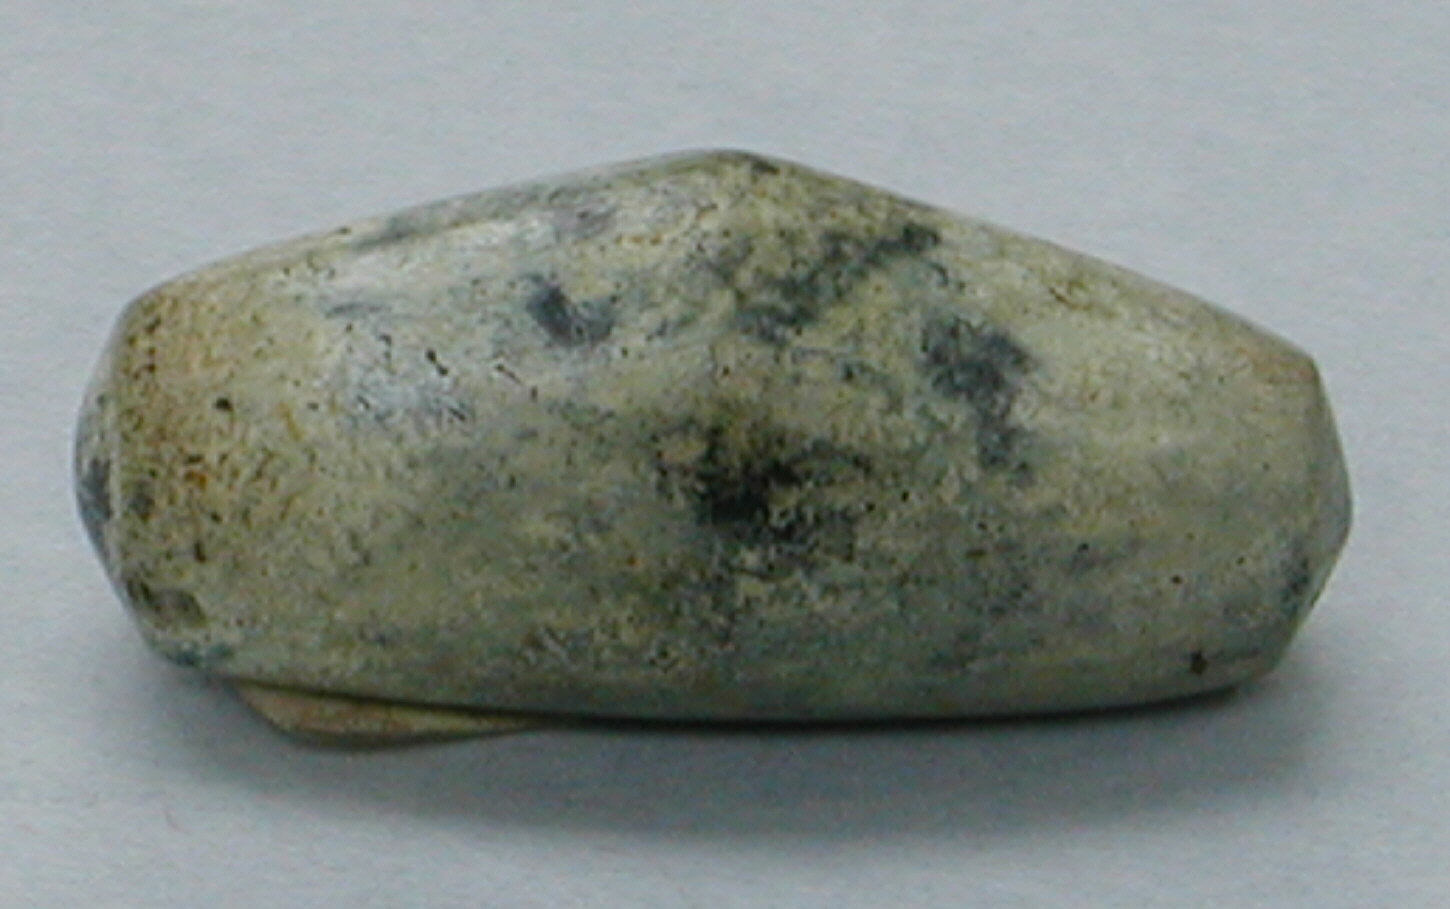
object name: ritual stone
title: Stone Pulidor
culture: mexican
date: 1501-1600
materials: stone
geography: mexico